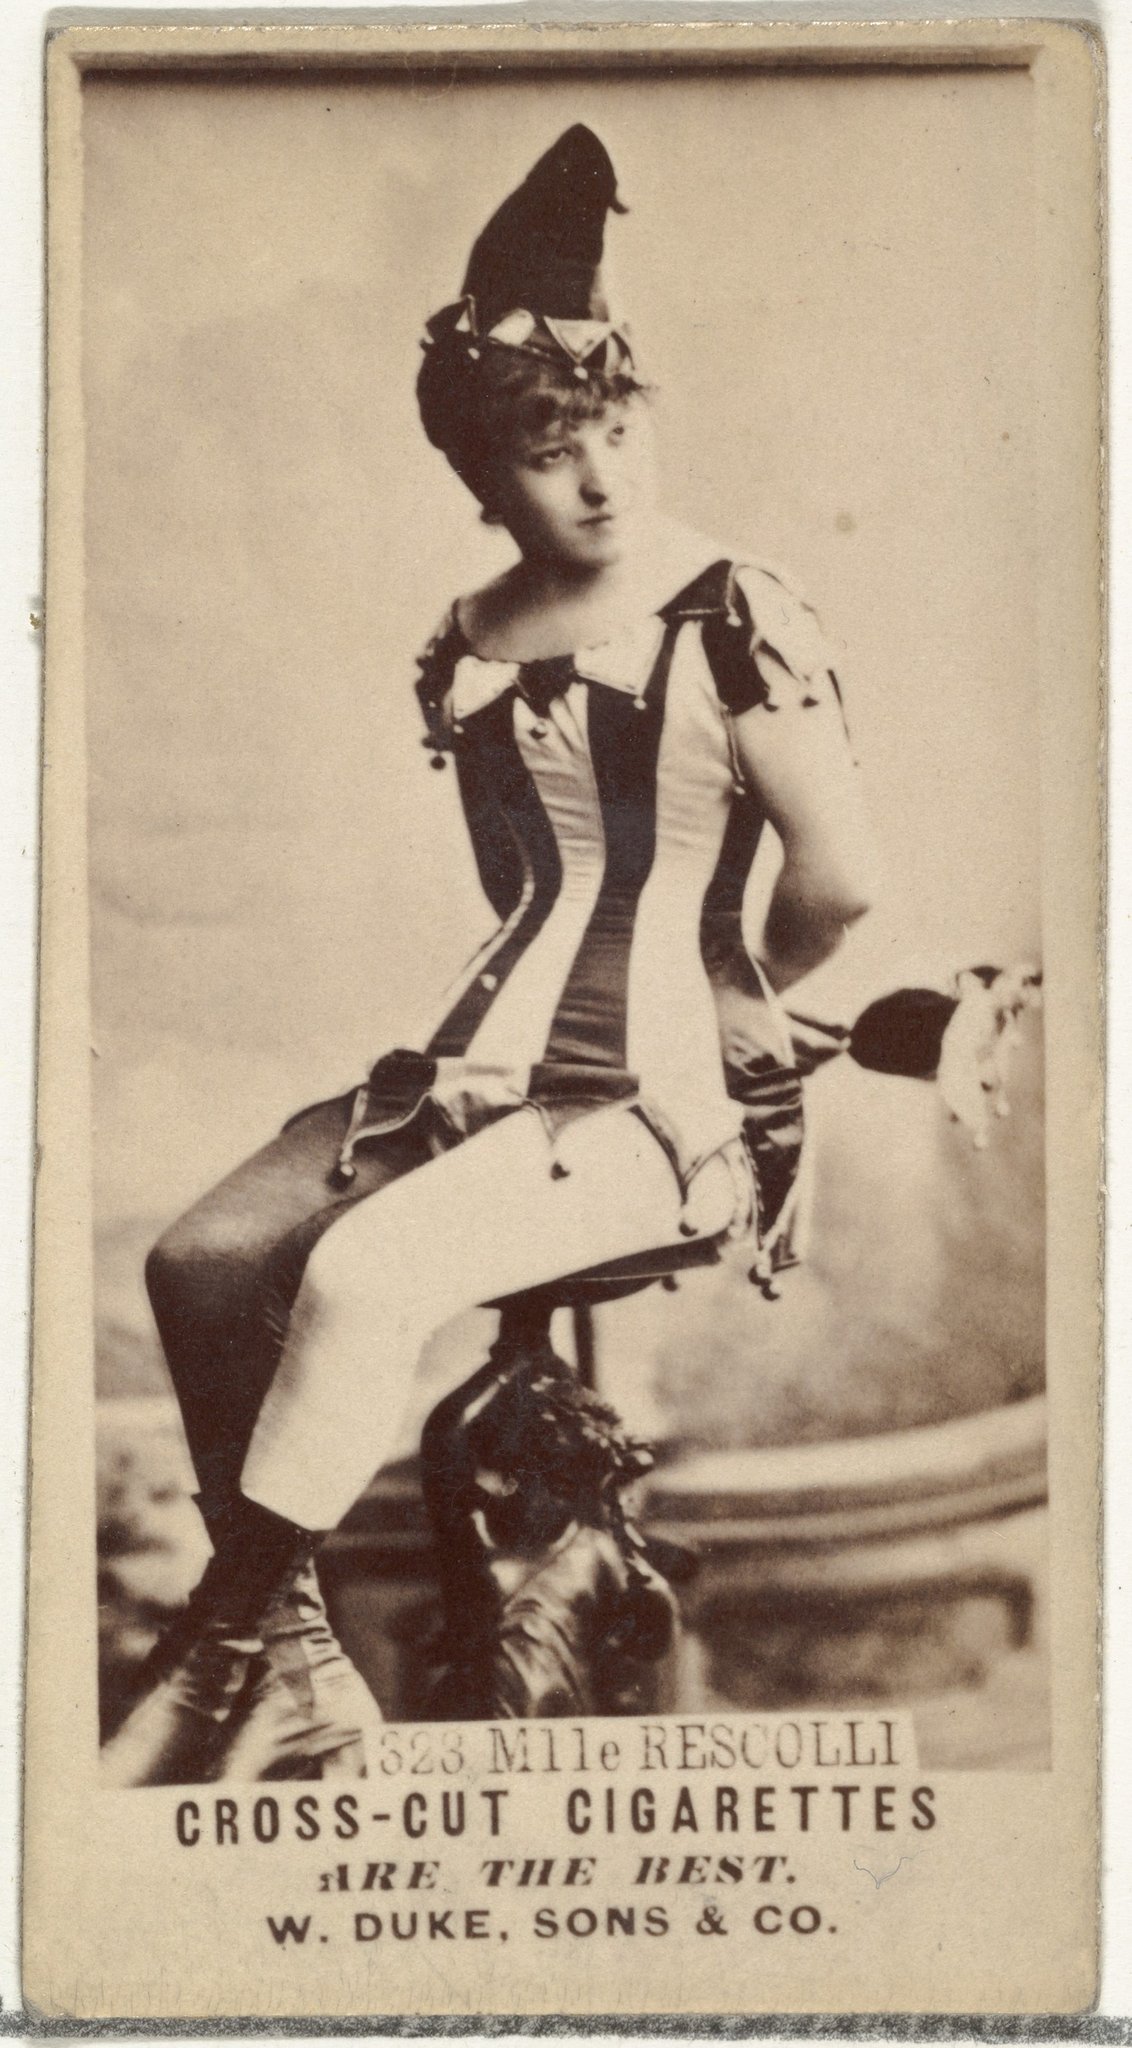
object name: photograph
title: Card Number 323, Mlle. Rescolli, from the Actors and Actresses series (N145-3) issued by Duke Sons & Co. to promote Cross Cut Cigarettes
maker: w. duke, sons & co.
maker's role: publisher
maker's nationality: american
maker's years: 1870-1920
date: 1880-1889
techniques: albumen silver print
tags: portraits,women,actresses